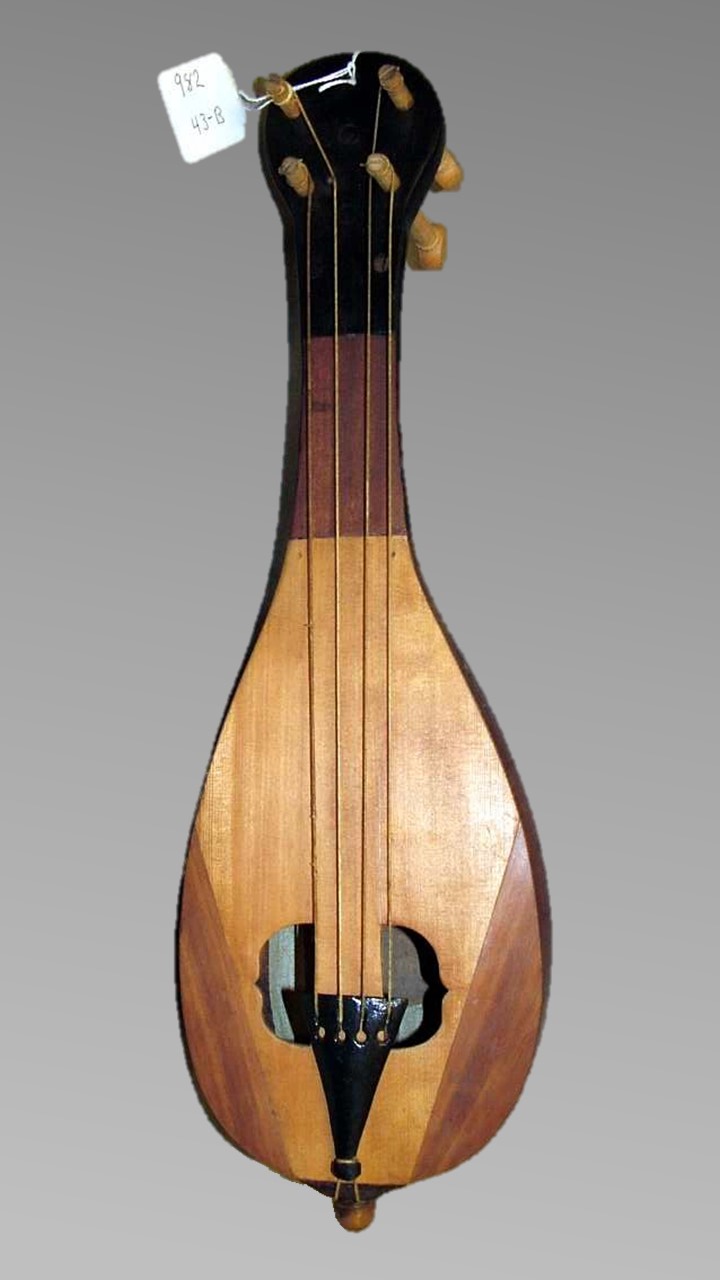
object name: rebec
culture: greek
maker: t. maurouoff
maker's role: maker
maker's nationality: greek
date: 1867-1900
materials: wood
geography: greece